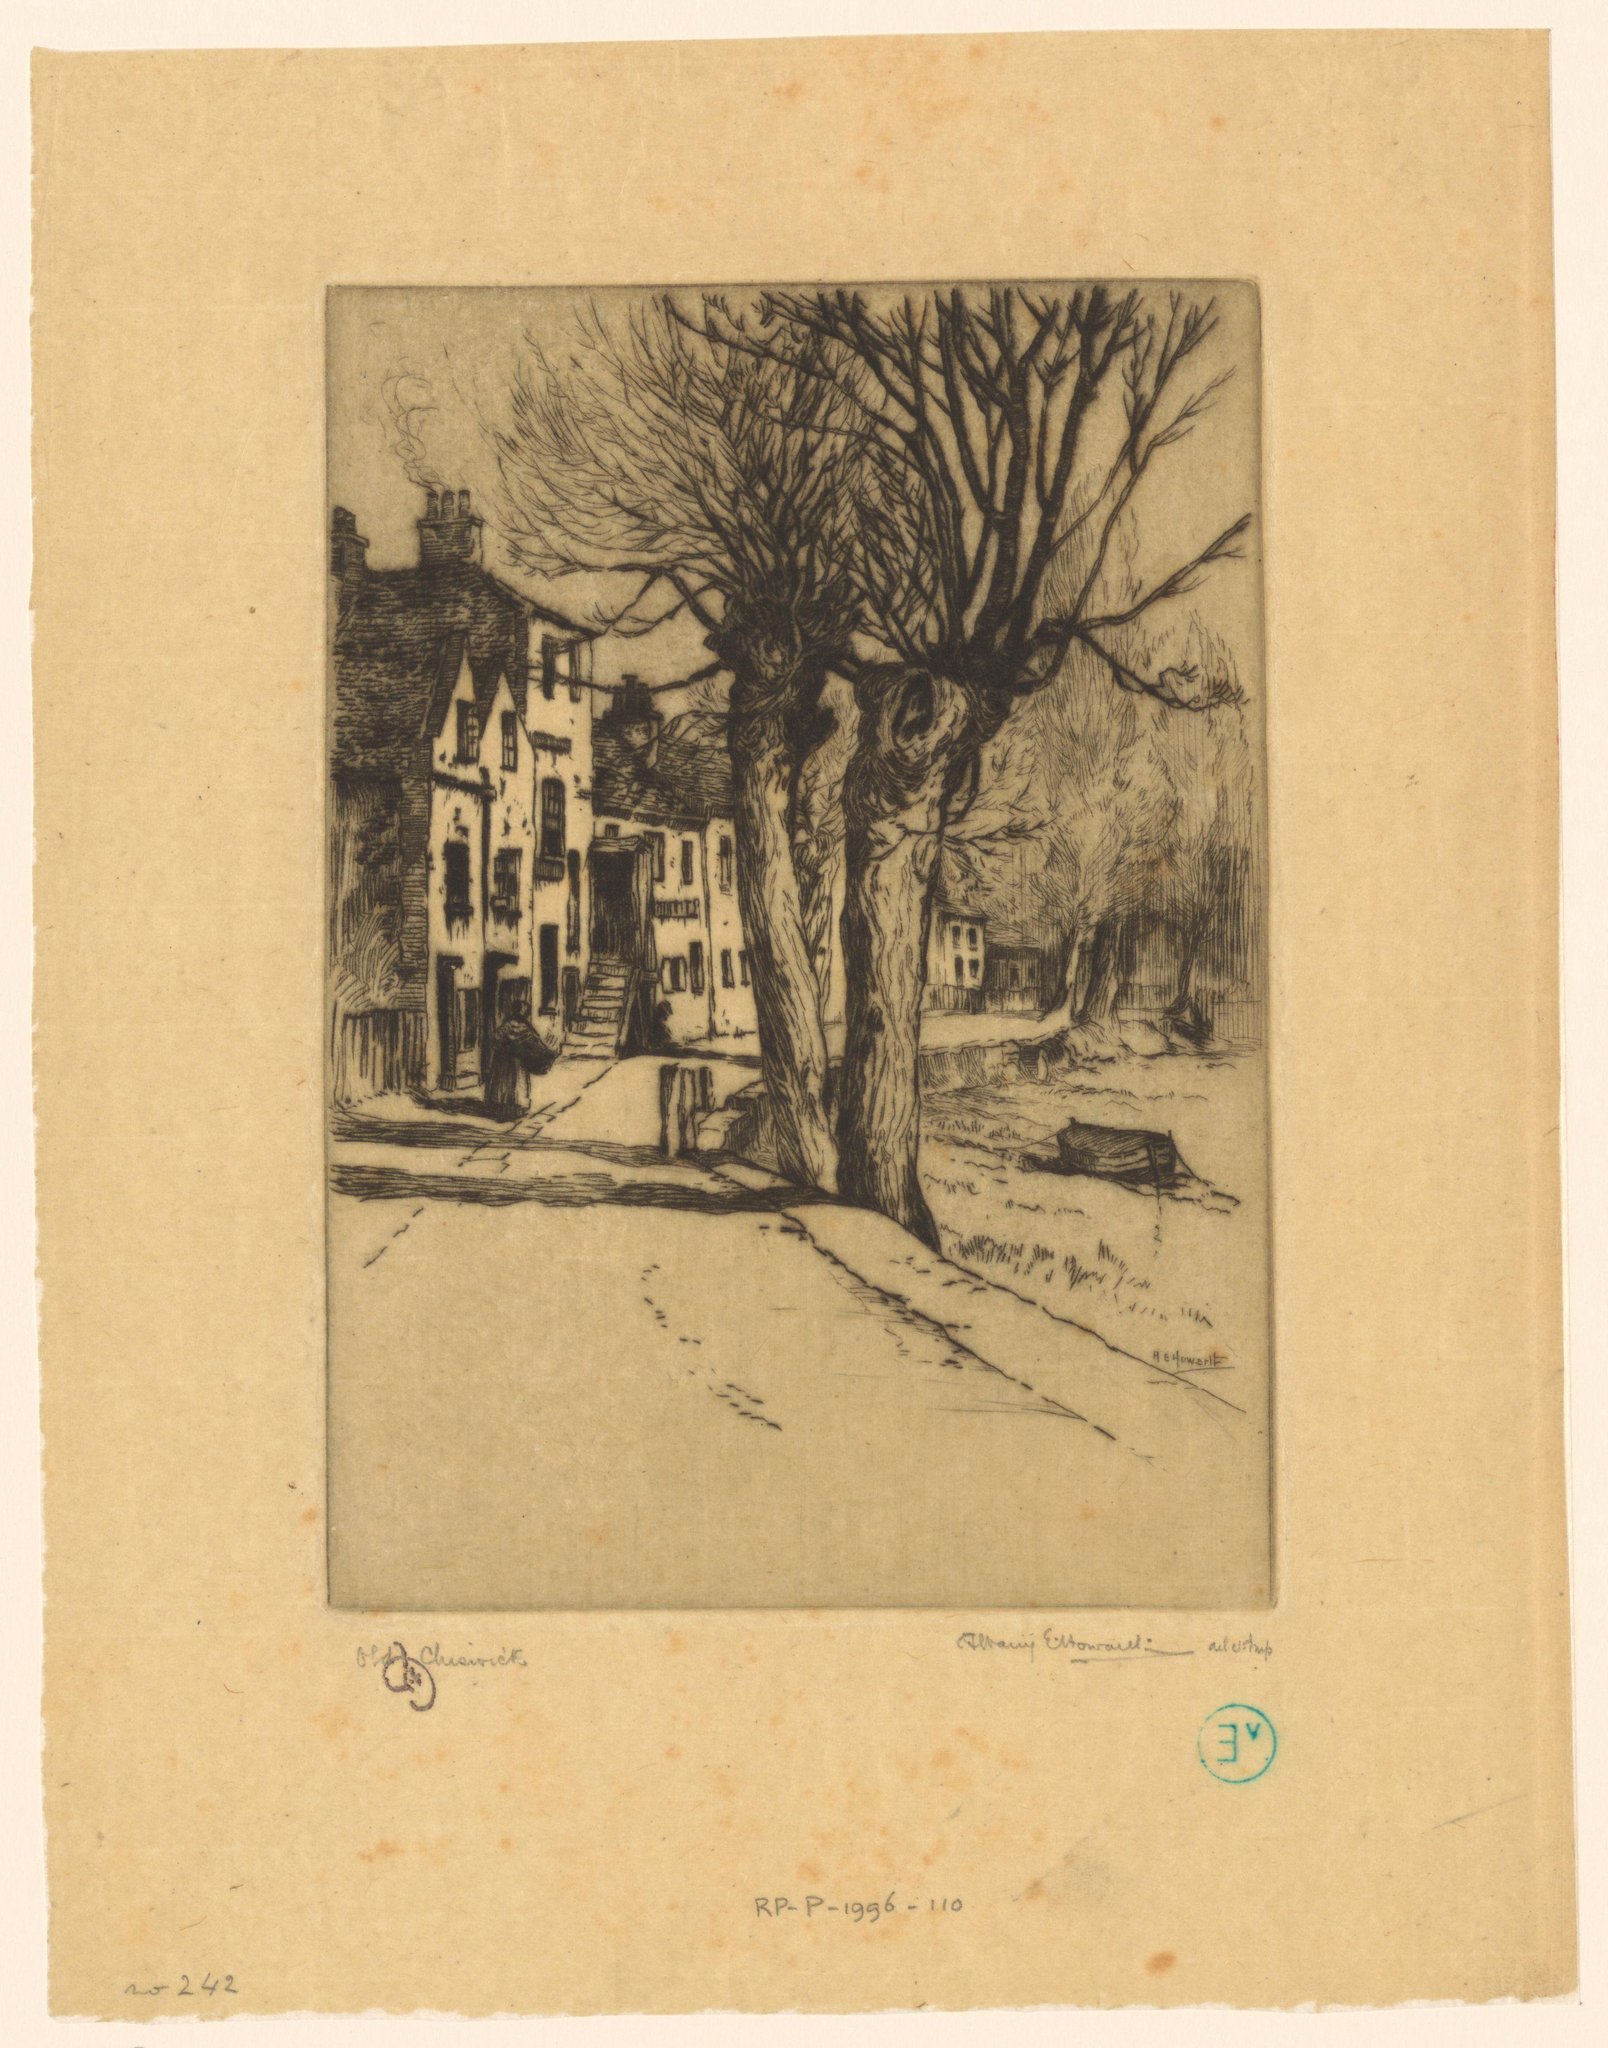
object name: print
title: Gezicht op een laan in Chiswick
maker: albany e. howarth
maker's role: print maker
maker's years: 1872-1936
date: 1882-1936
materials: paper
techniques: etching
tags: village lane, alley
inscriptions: collector's mark: Lugt 4731, collector's mark: Lugt 5101